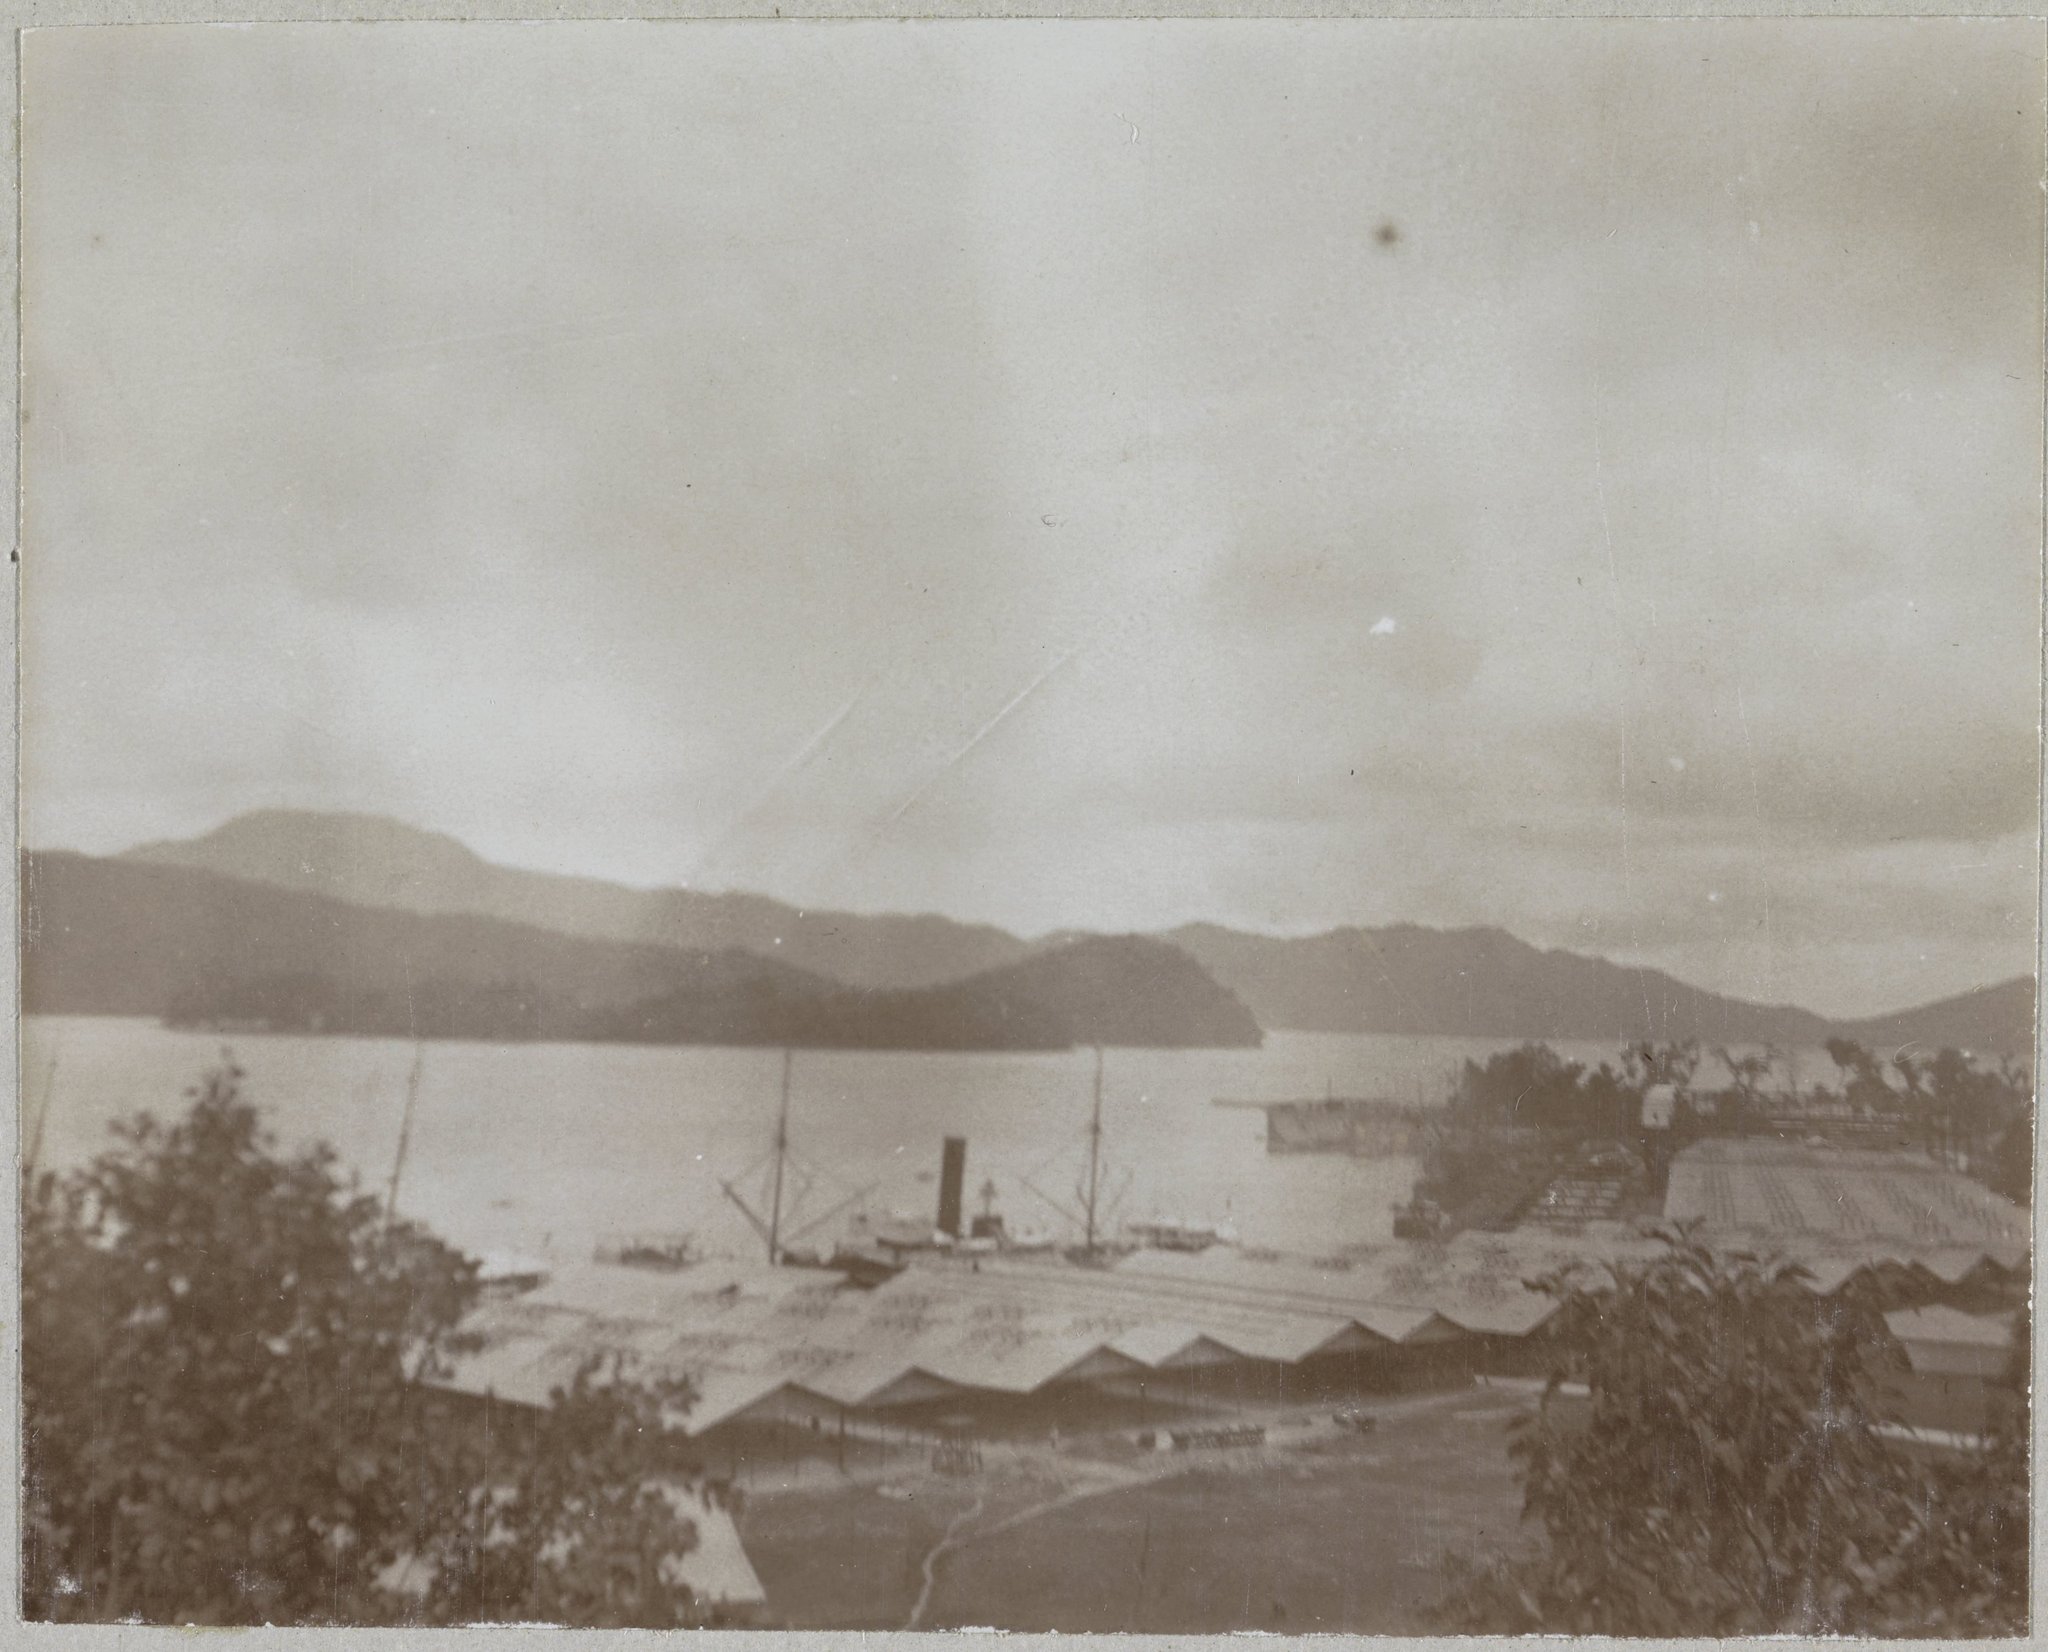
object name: photograph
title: Haven van Sabang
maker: Anonymous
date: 1895-1915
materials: cardboard, paper, photographic support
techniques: collodion silver print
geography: sabang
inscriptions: annotation: ‘1) haven van Sabang.’